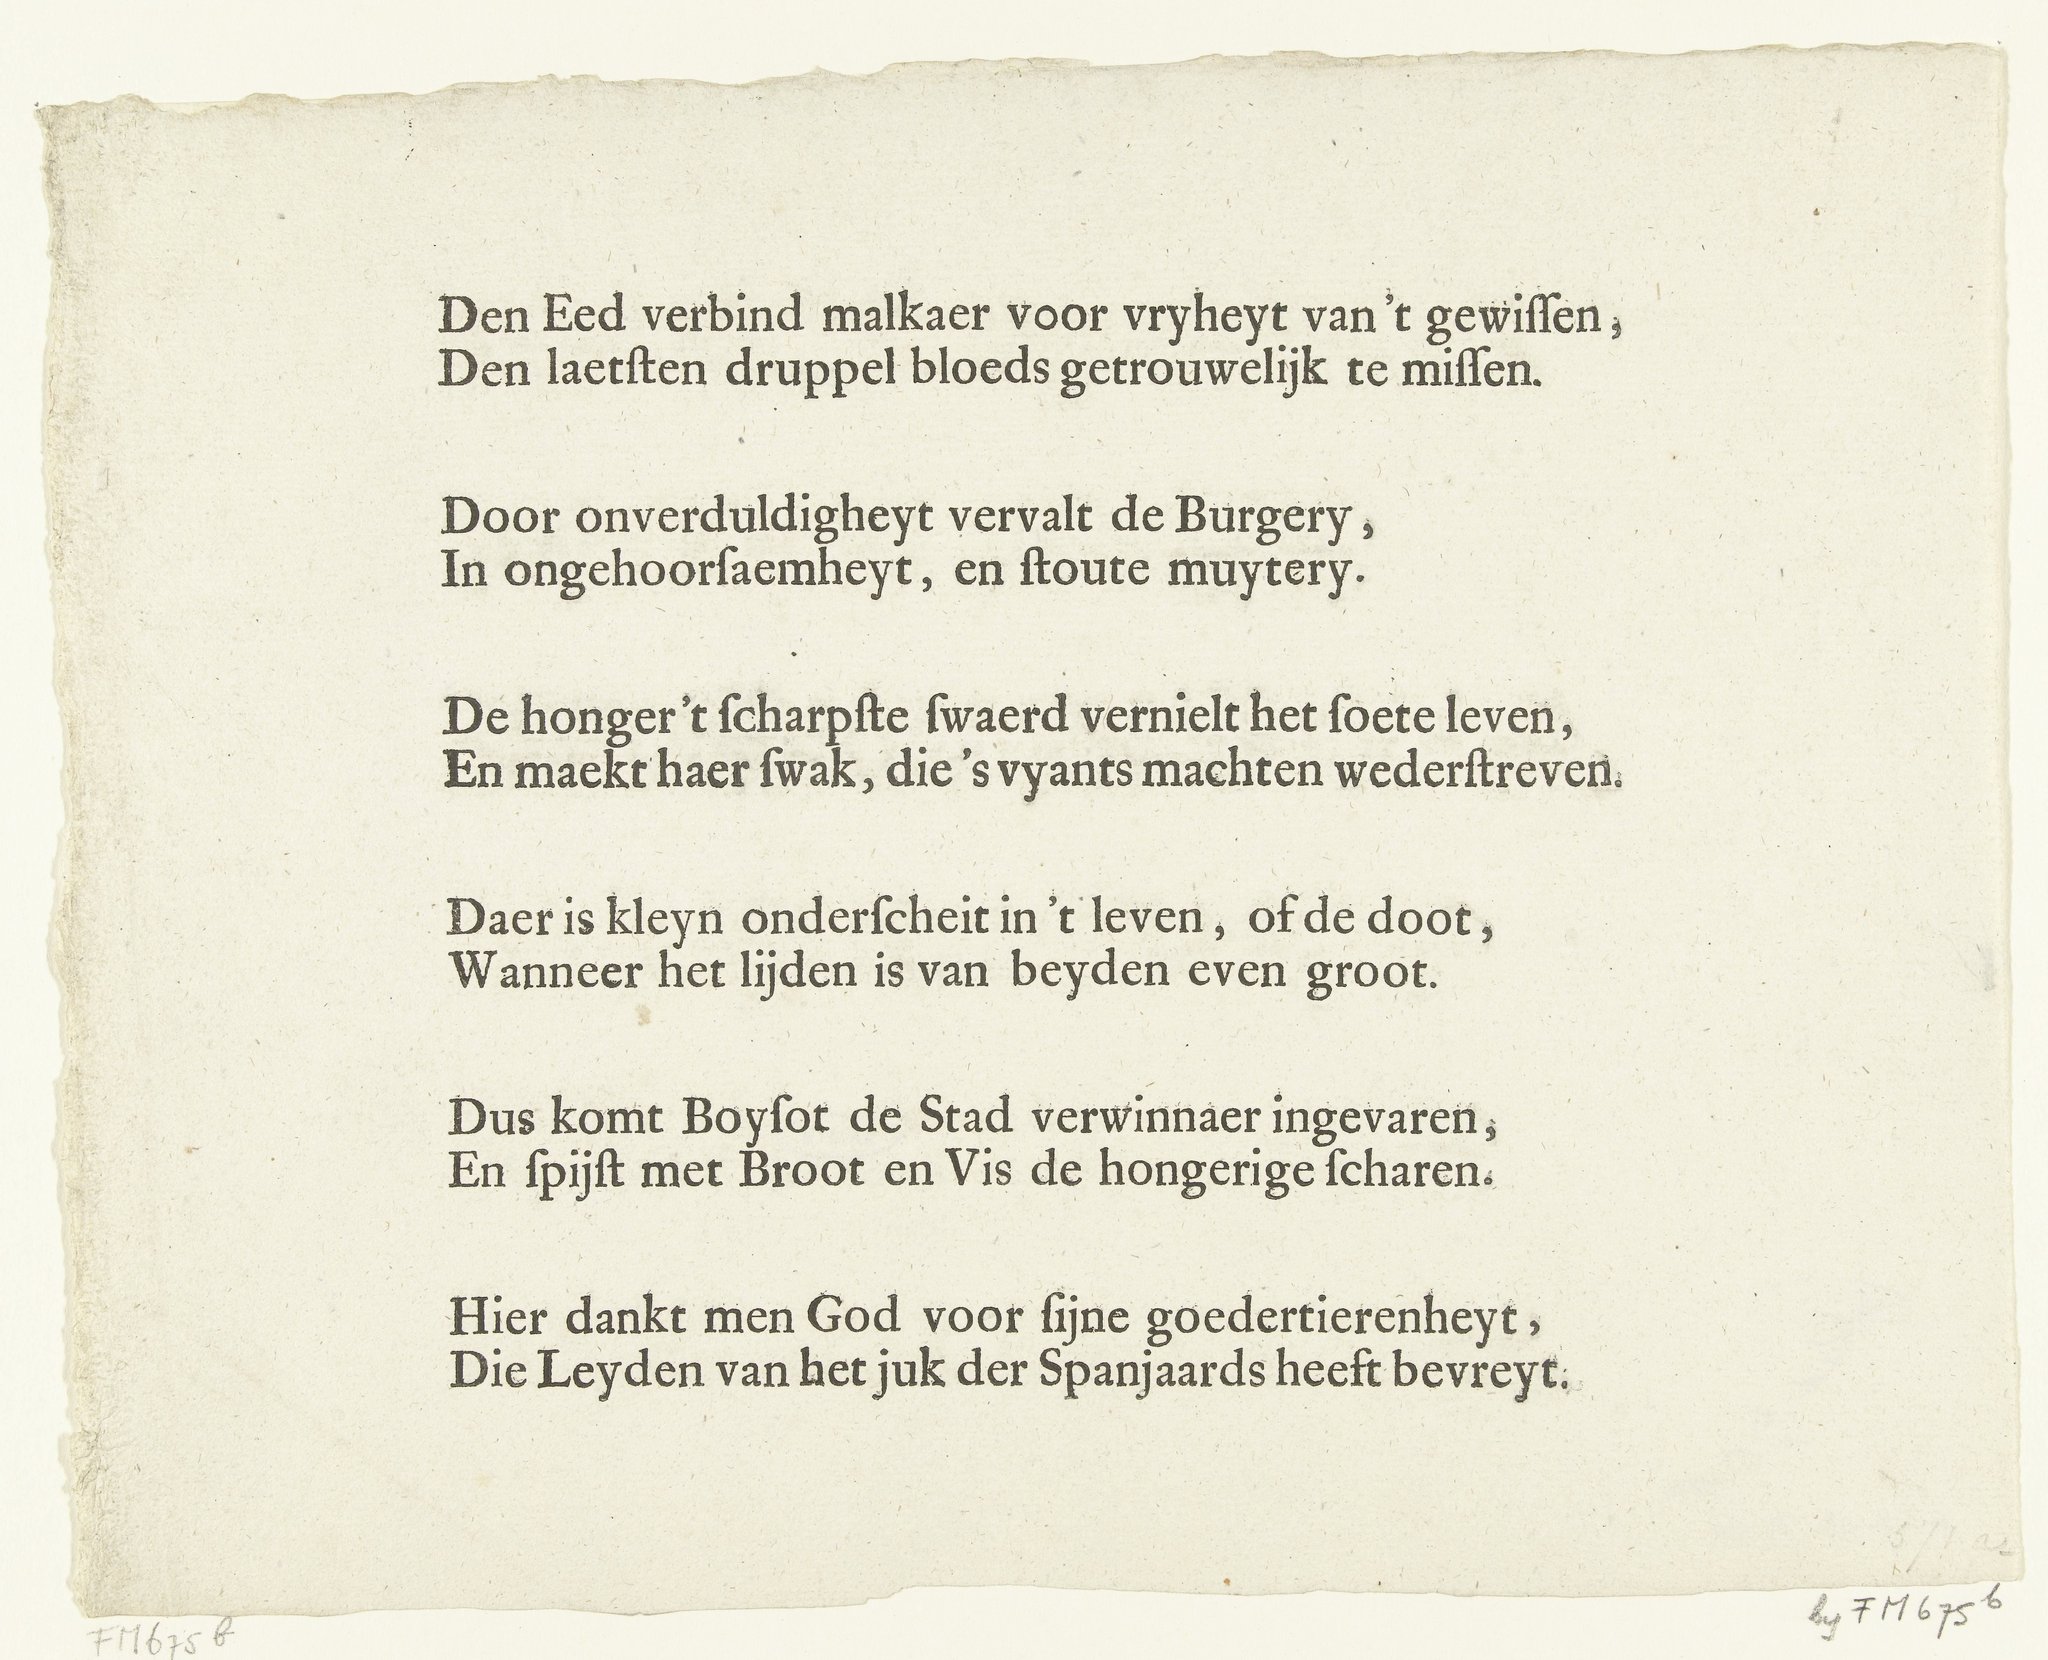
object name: text sheet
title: Blad met zes tweeregelige verzen over het beleg en ontzet van Leiden, 1574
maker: Anonymous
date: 1614-1699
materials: paper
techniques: letterpress printing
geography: northern netherlands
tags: leiden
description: Blad met zes tweeregelige verzen over het beleg en ontzet van Leiden, 1574. Waarschijnlijk behorend bij de serie: Leiden tijdens het beleg en ontzet, 1574 (kopieën).